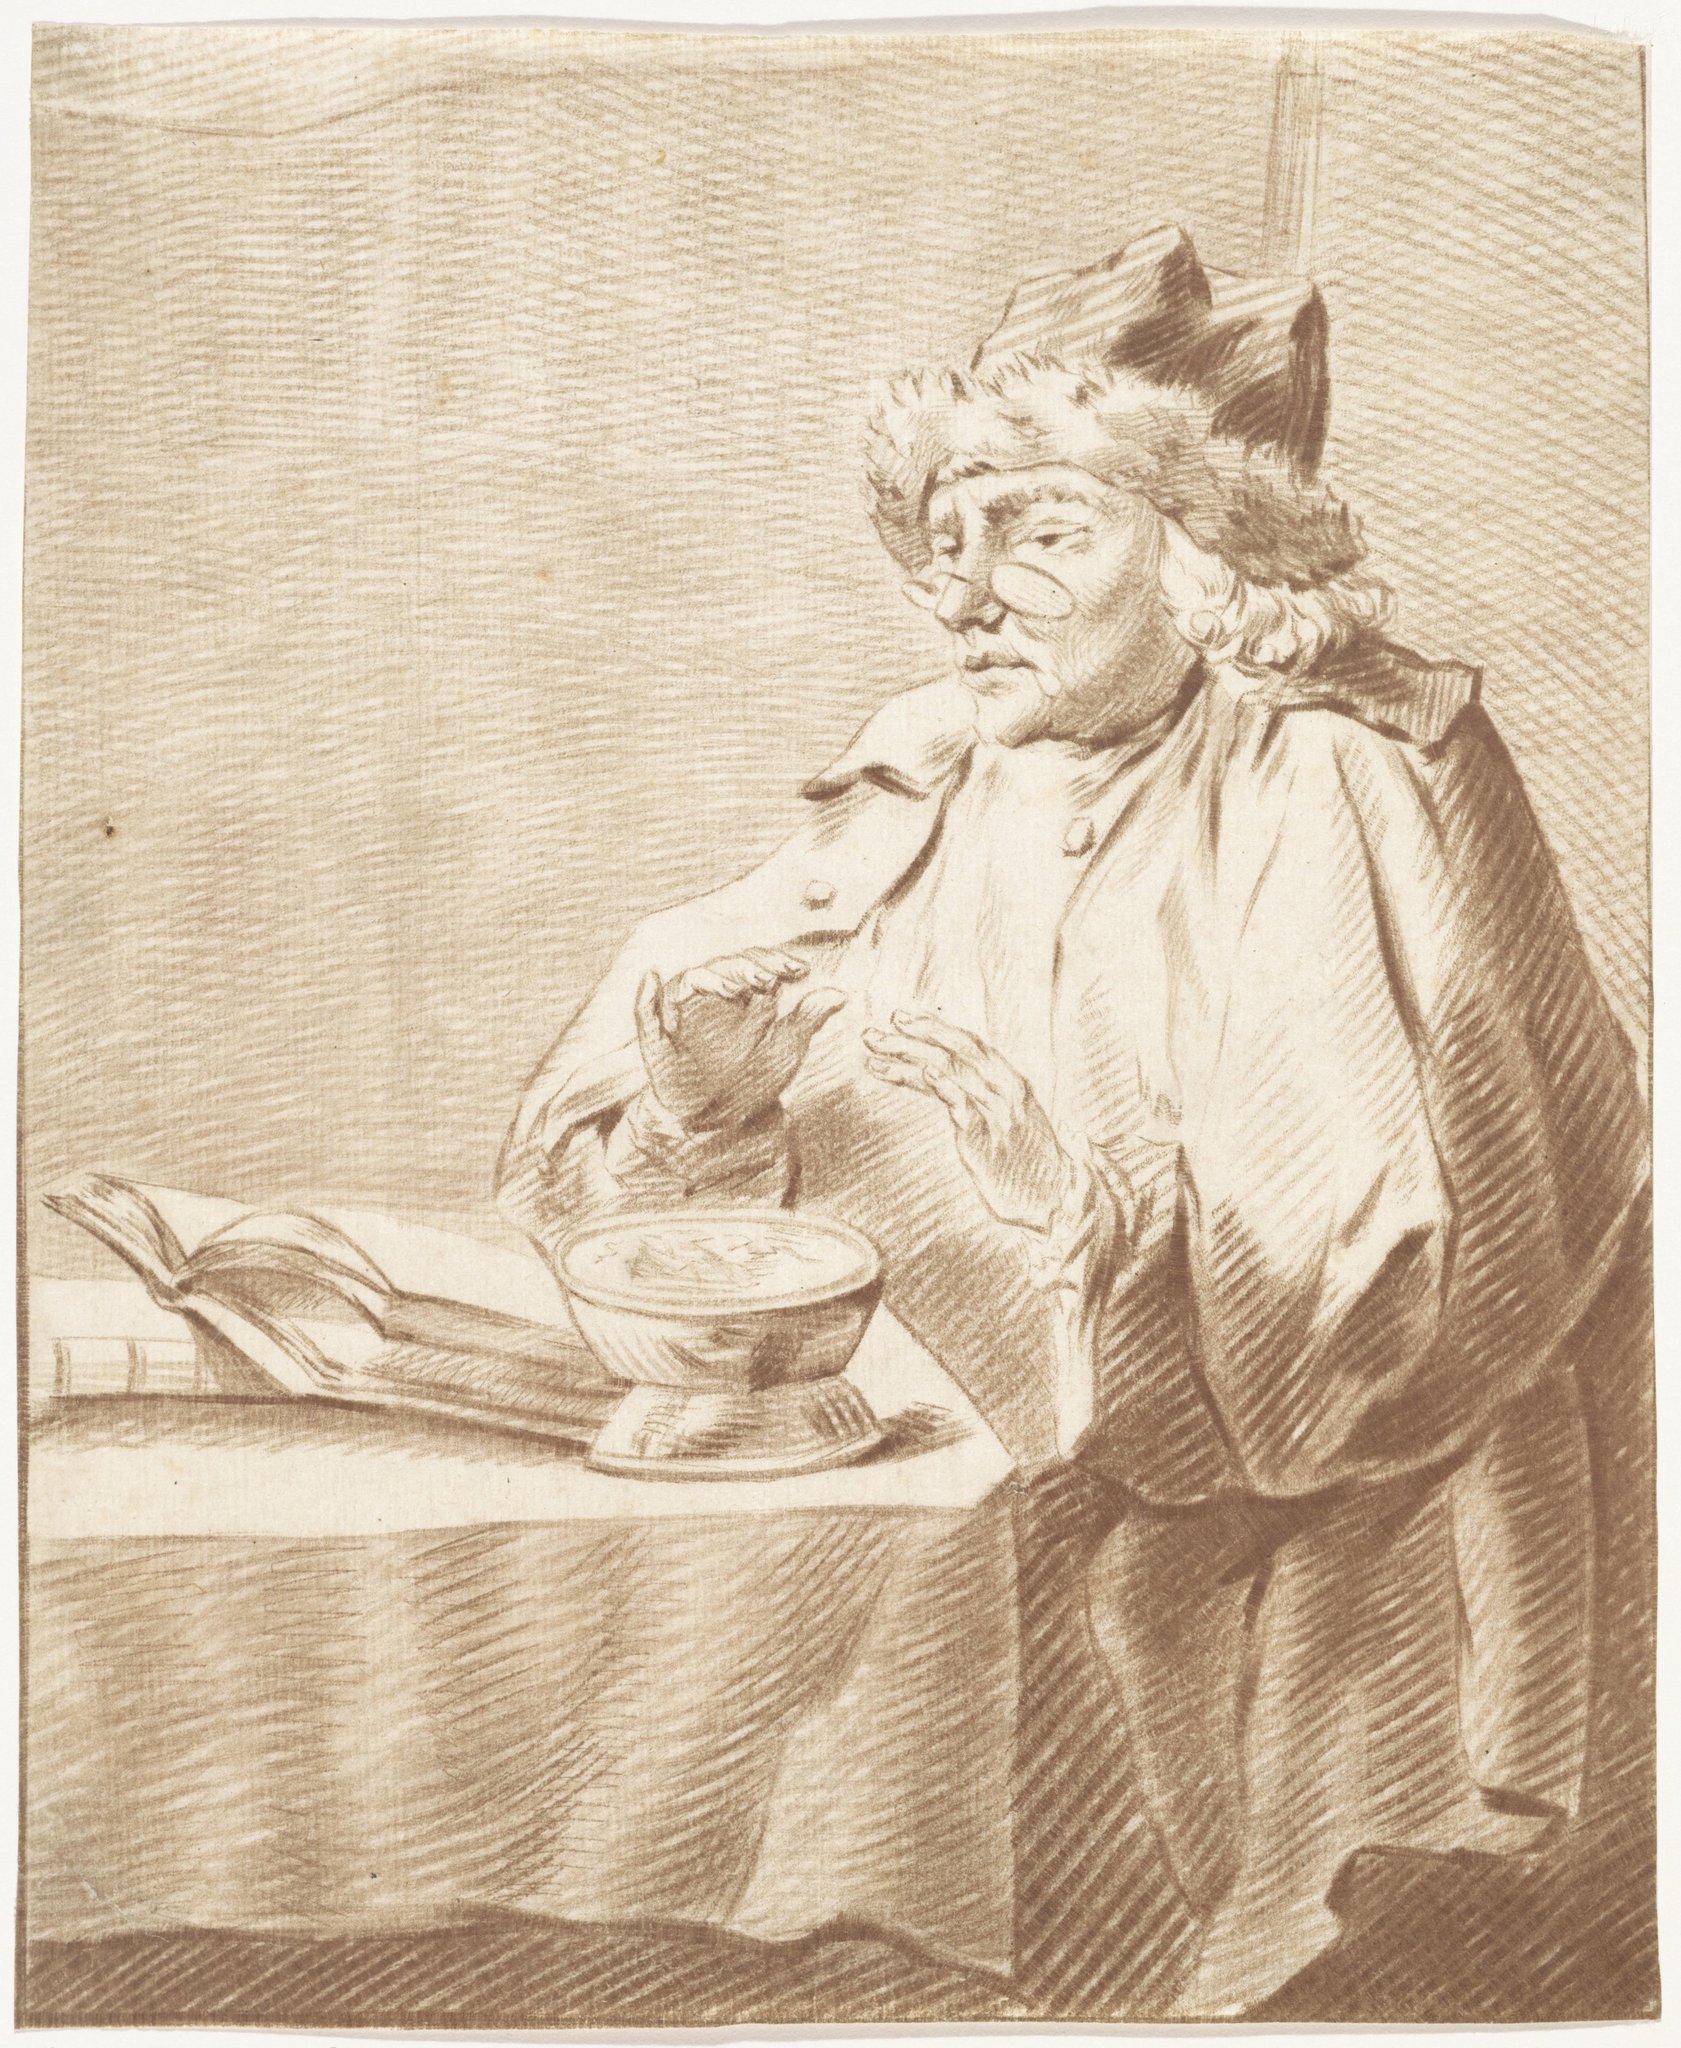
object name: print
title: Portret van Jurraan Buttner bij een komfoor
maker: izaak jansz. de wit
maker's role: draughtsman, print maker, publisher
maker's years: 1744-1809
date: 1754-1809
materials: paper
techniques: printing, printmaking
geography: haarlem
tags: amsterdam, painter, eyeglasses, spectacles, warming oneself at a fire (or hearth, stove, fire-pan, brazier), head-gear: cap (+ men's clothes), heating stove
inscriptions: collector's mark: Lugt 2228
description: De schilder Jurriaan Buttner zittende voor een tafel waarop een komfoor waarboven hij zijn handen warmt. Hj draagt een muts en heeft een bril op zijn neus.